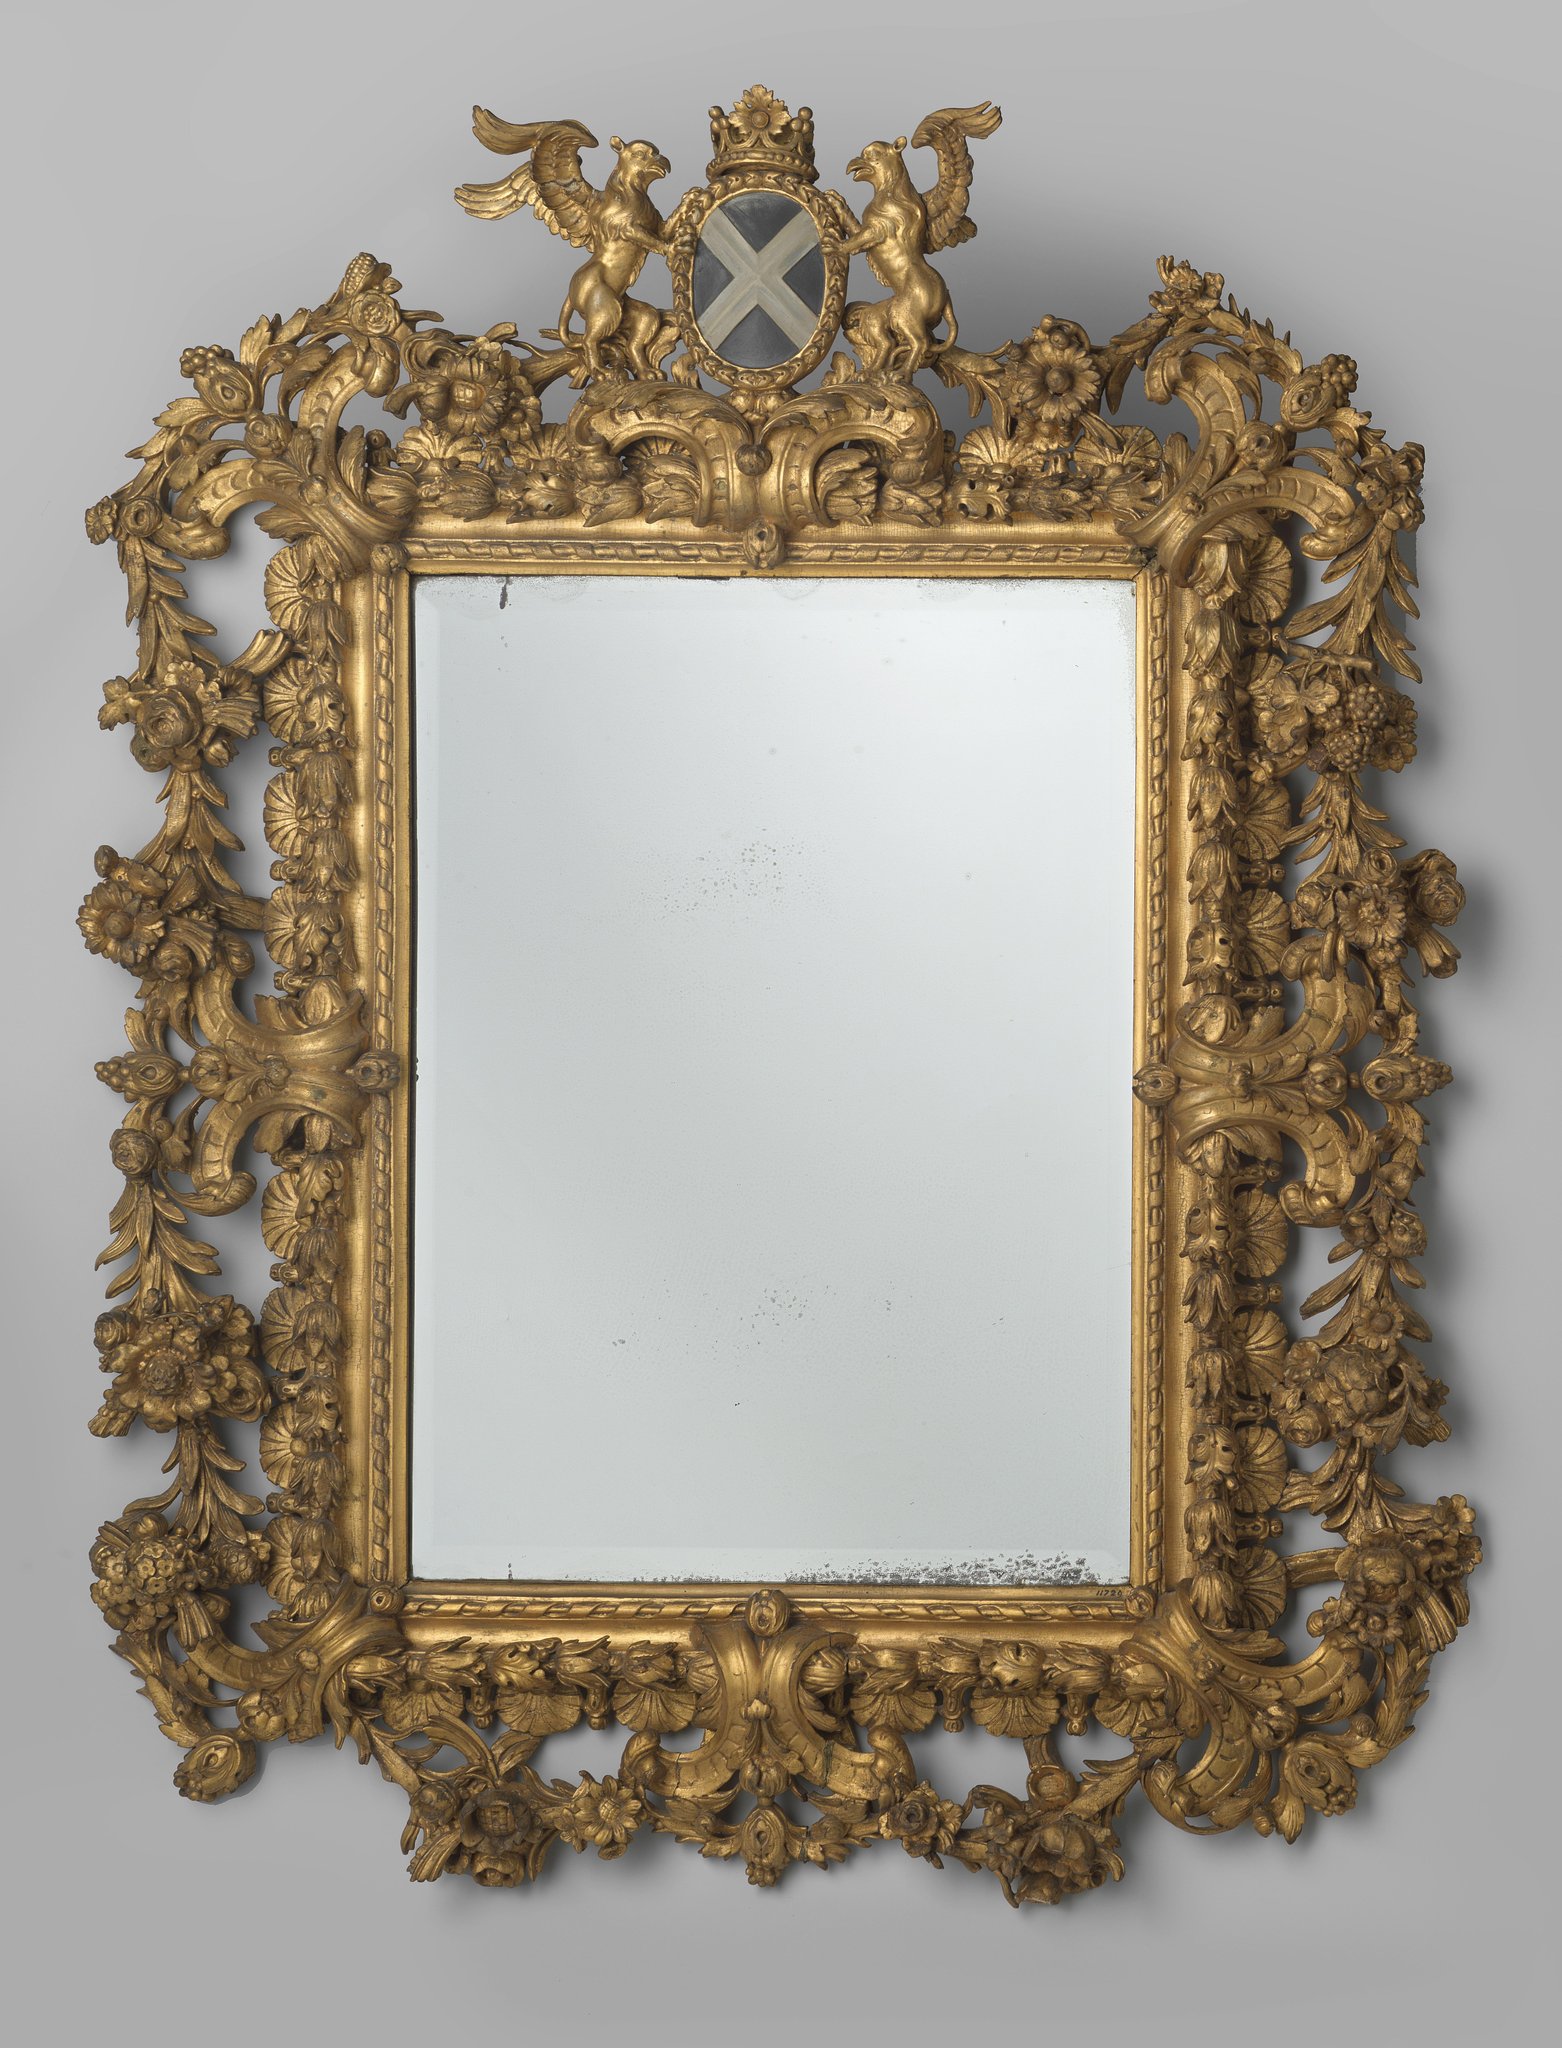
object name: frame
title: Spiegellijst met wapen Hoeufft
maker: Anonymous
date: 1680-1700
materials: amalgam, glass, wood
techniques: gilding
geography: northern netherlands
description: Spiegel- of schilderijlijst van verguld lindehout, versierd met rijk gesneden, gedeeltelijk opengewerkte beugels aan de hoeken en het midden der zijden, en met bloemfestoenen. Bovenis wordt het wapen der familie Hoeufft vastgehouden door twee griffioenen. Het verguldsel en het gefacetteerde glas zijn vernieuwd.